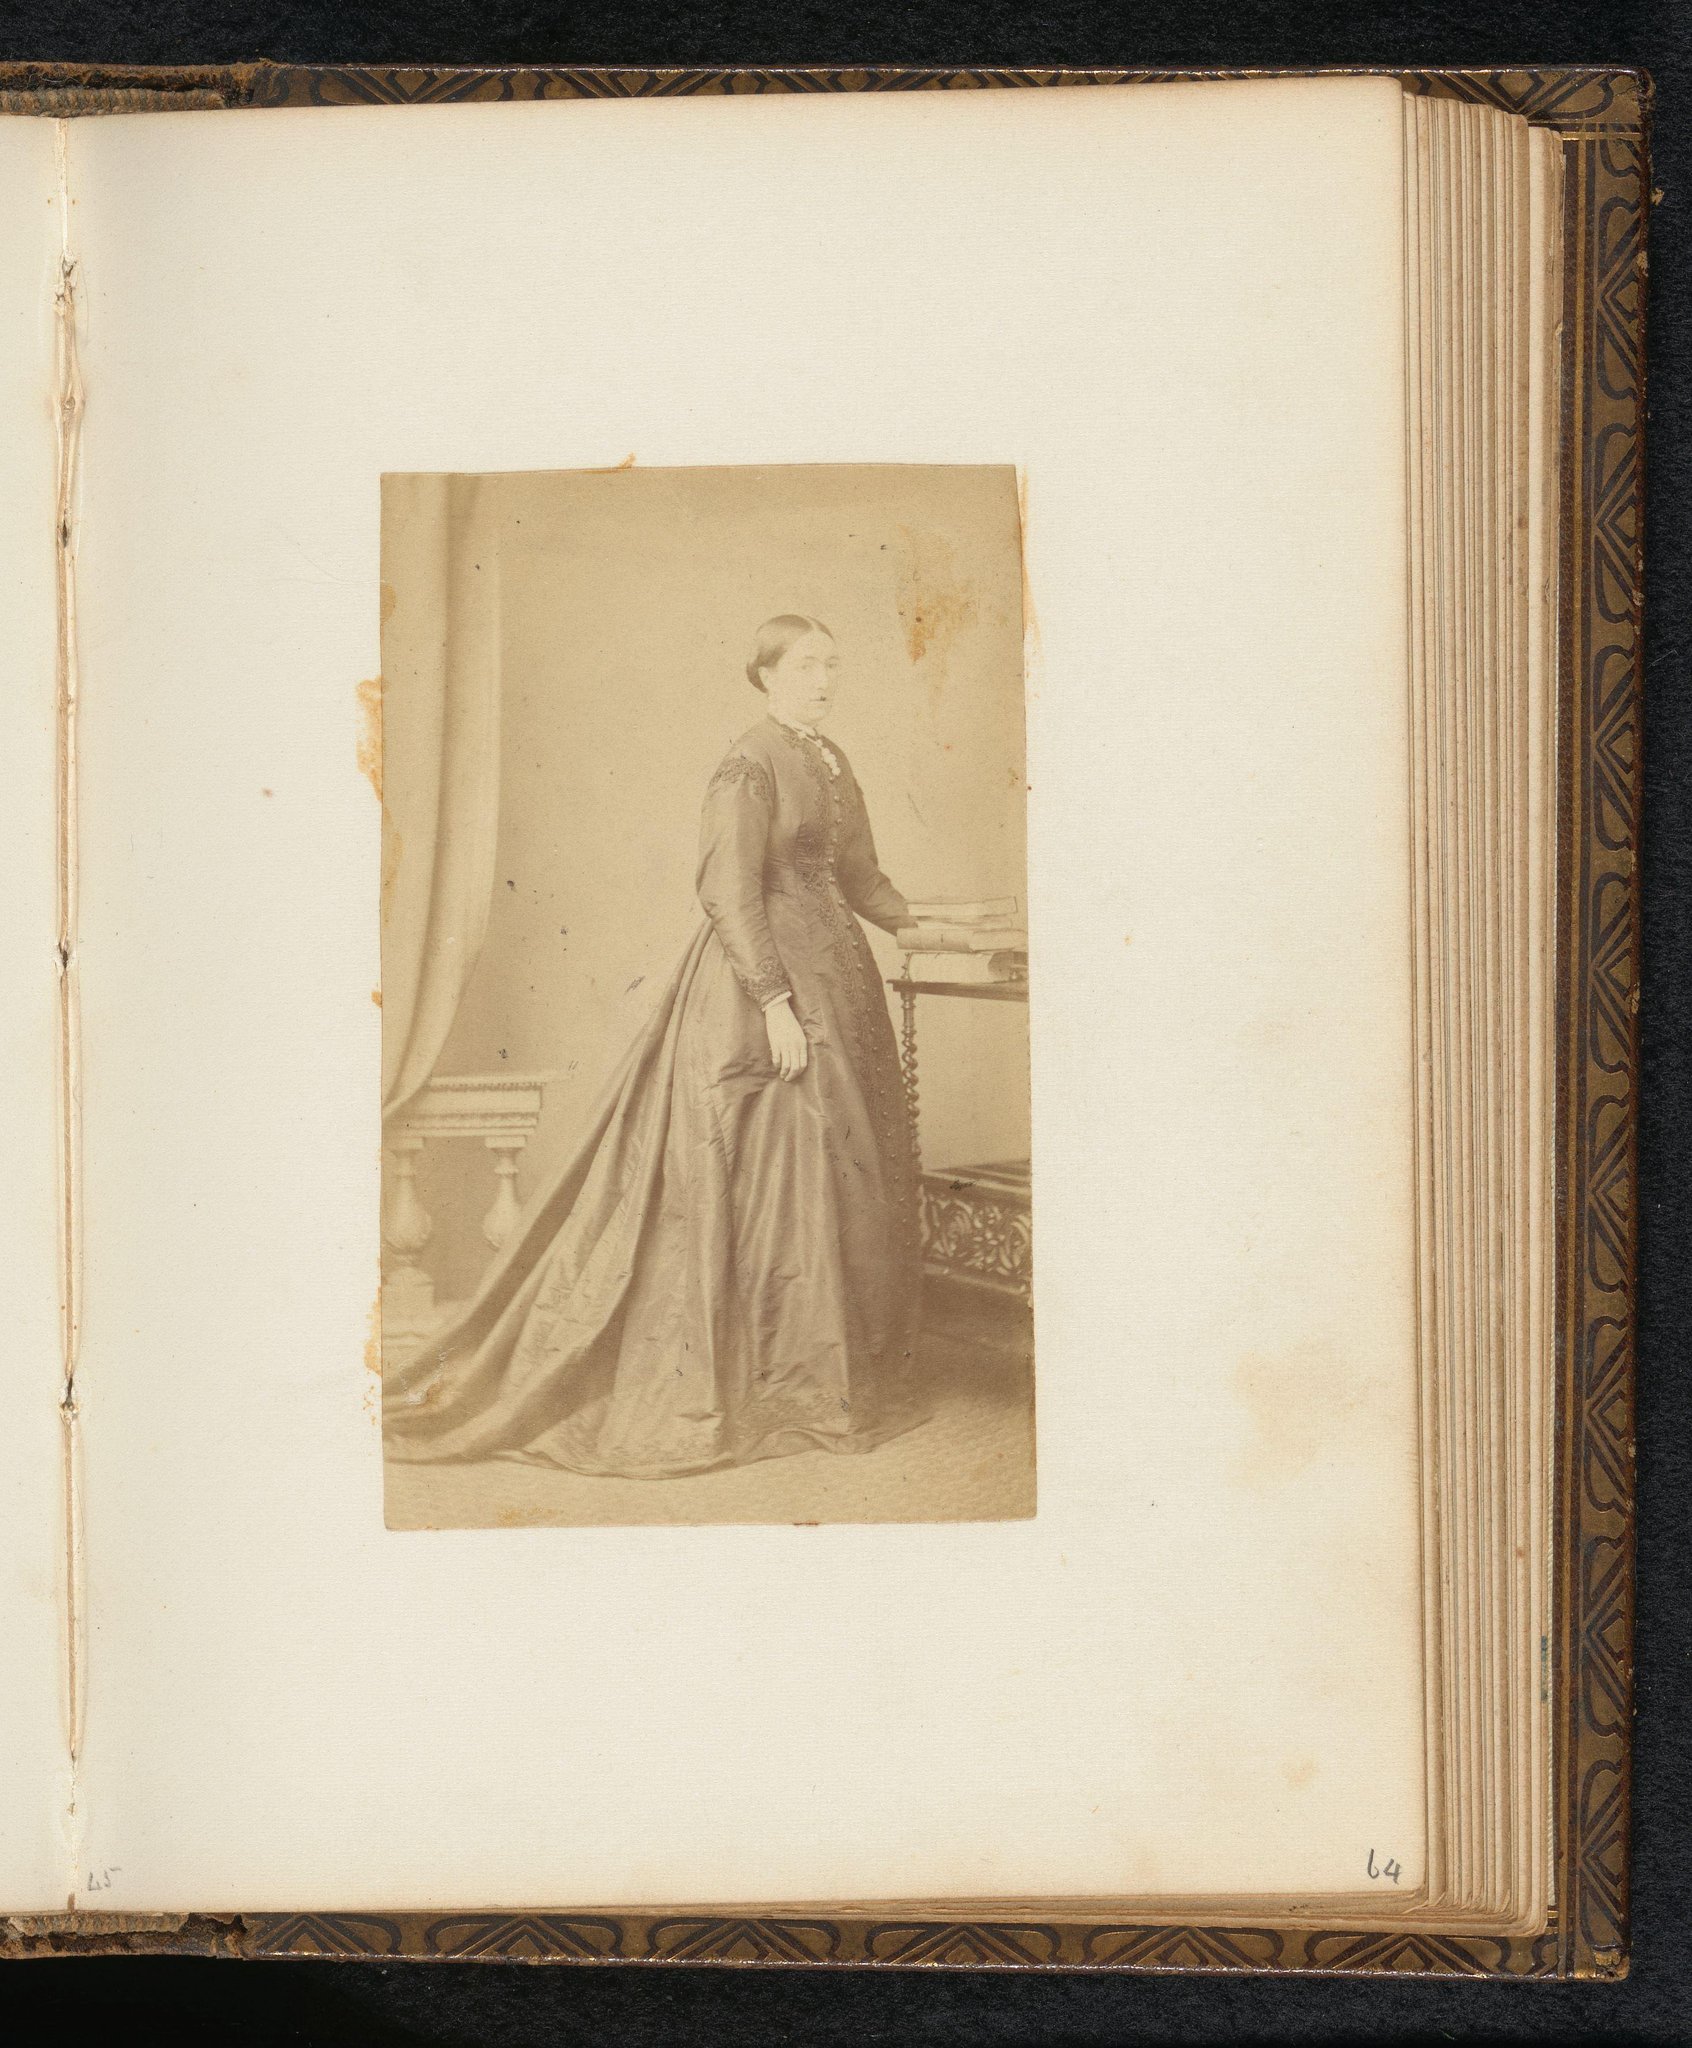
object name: album leaf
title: Portret van vrouw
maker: Anonymous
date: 1865-1867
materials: cardboard, photographic support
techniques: albumen print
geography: england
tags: anonymous historical person portrayed - bb - woman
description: Portret van een onbekende vrouw, staande naast een tafel met boeken. Foto op albumblad in album met 68 foto's merendeels met geaquarelleerde randversieringen. Het zijn voornamelijk portretten op carte-de-visite formaat.